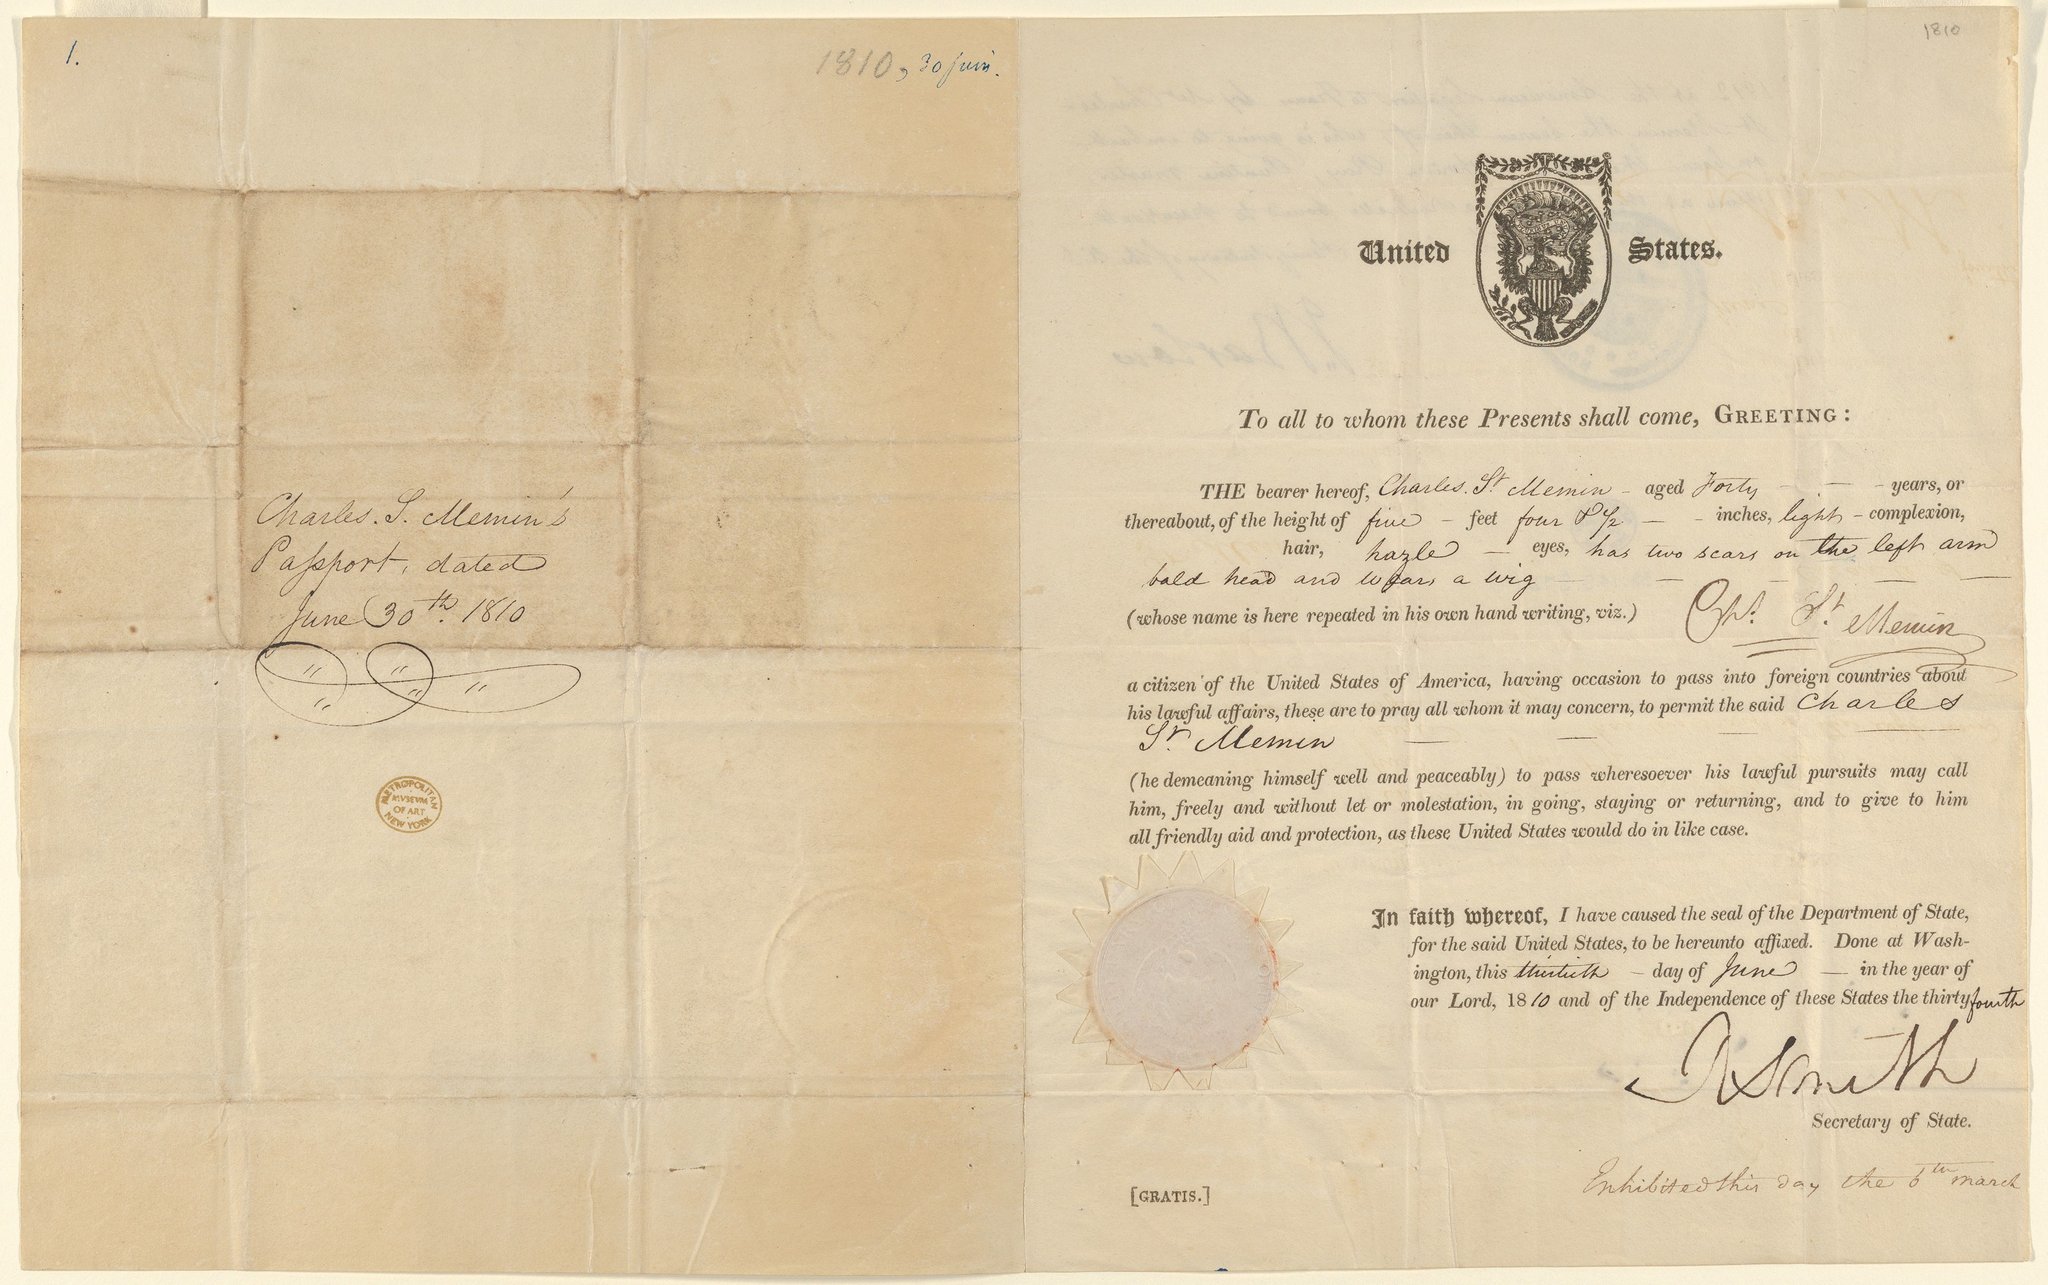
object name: document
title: Charles Saint-Mémin's American Passport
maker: charles b. j. f. de saint-mémin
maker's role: subject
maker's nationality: french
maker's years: 1770-1852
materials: ink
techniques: letterpress, pen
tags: documents